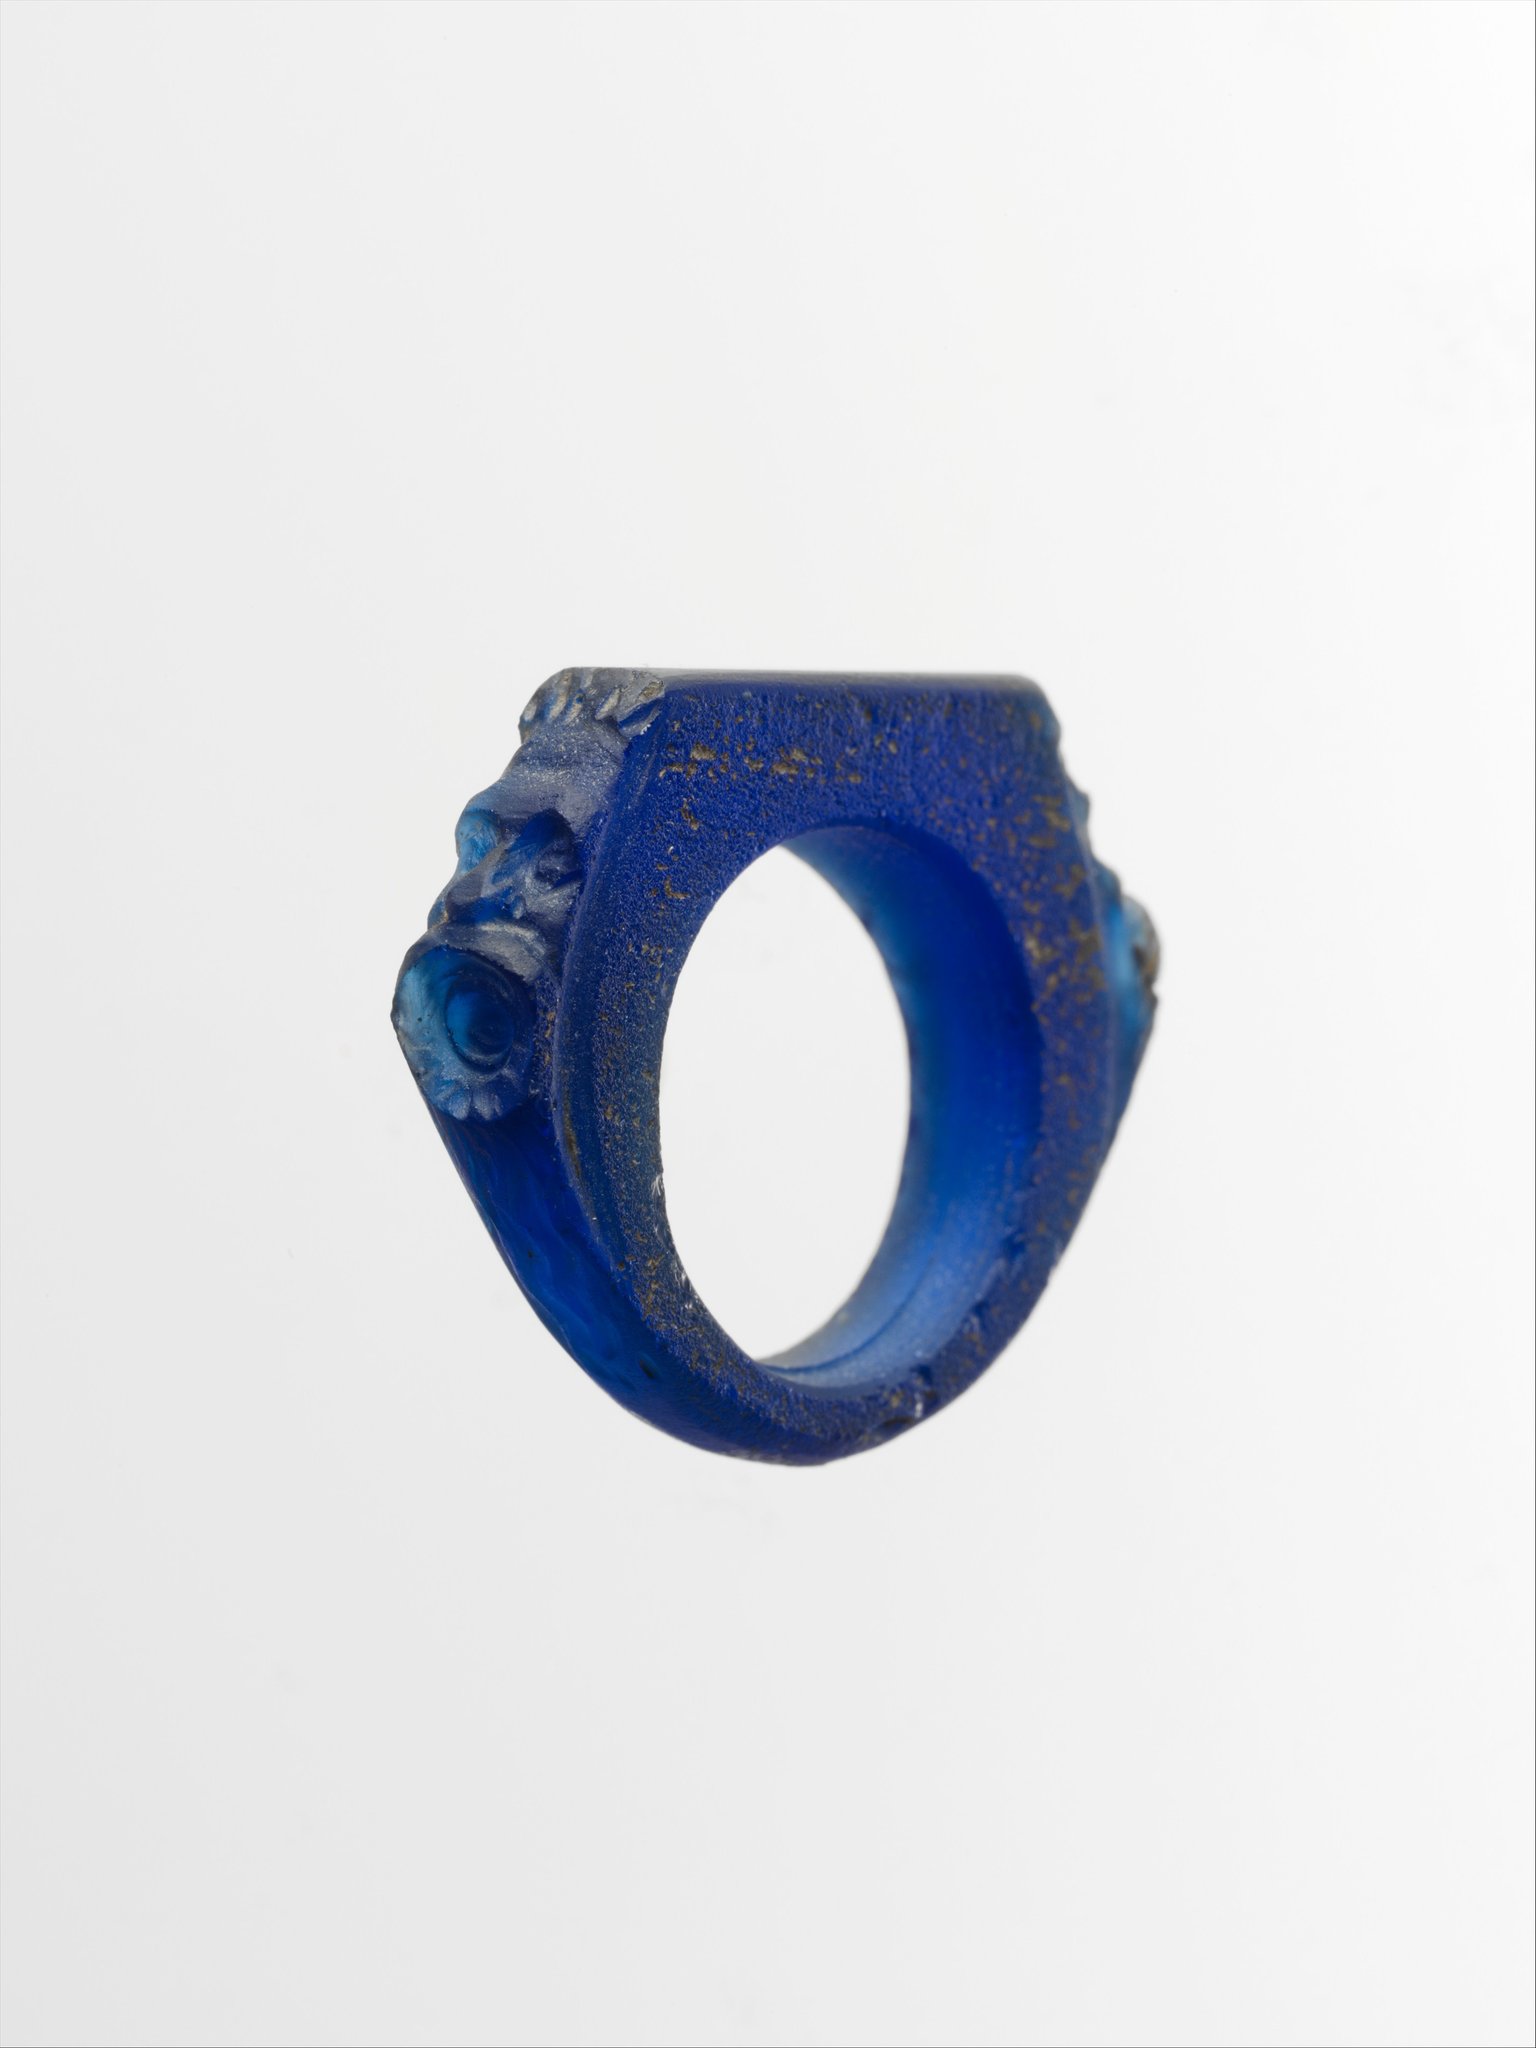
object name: ring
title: Glass finger ring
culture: roman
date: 201-300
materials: glass